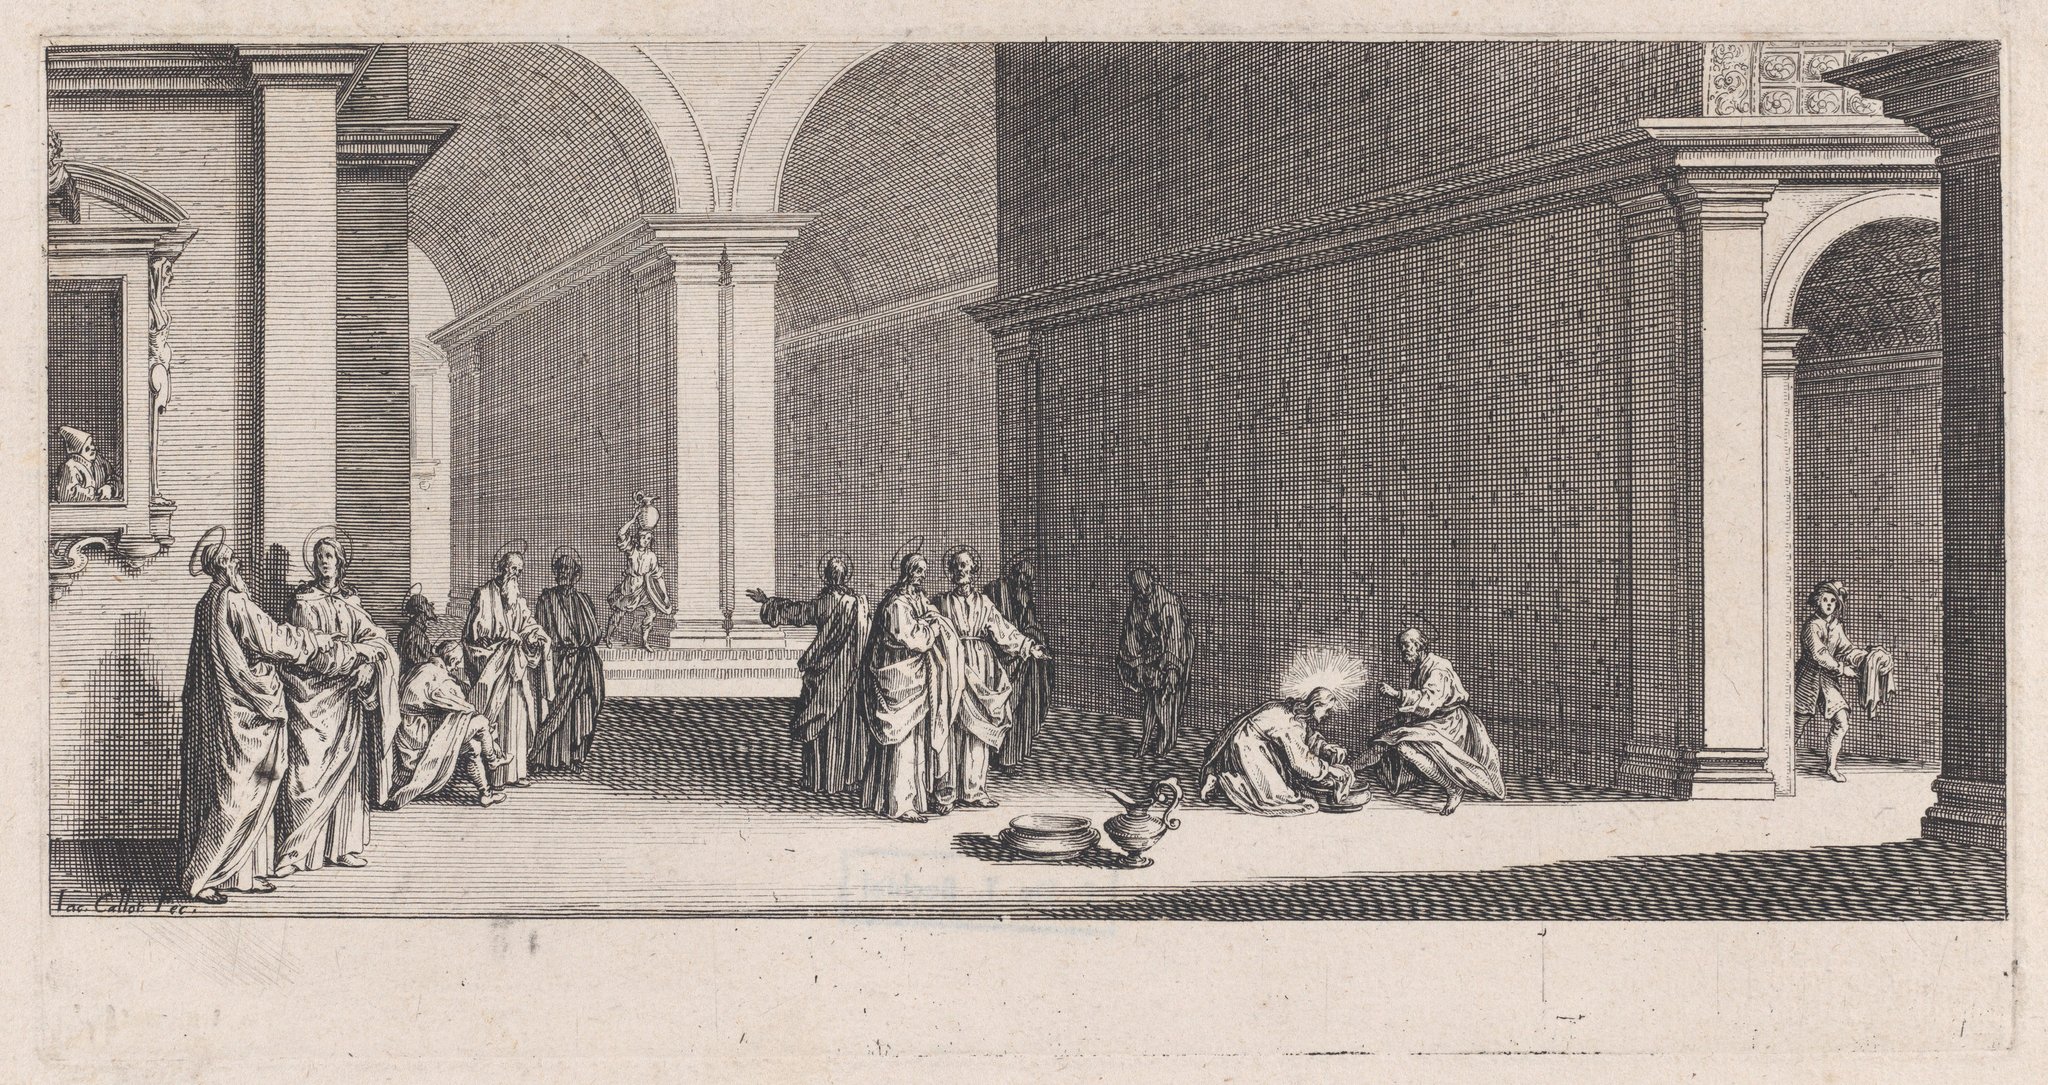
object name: print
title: Le Lavement des Pieds (The Washing of the Feet), from "La Grande Passion" (The Large Passion)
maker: jacques callot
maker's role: artist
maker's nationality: french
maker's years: 1592-1635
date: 1619-1624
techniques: engraving, etching